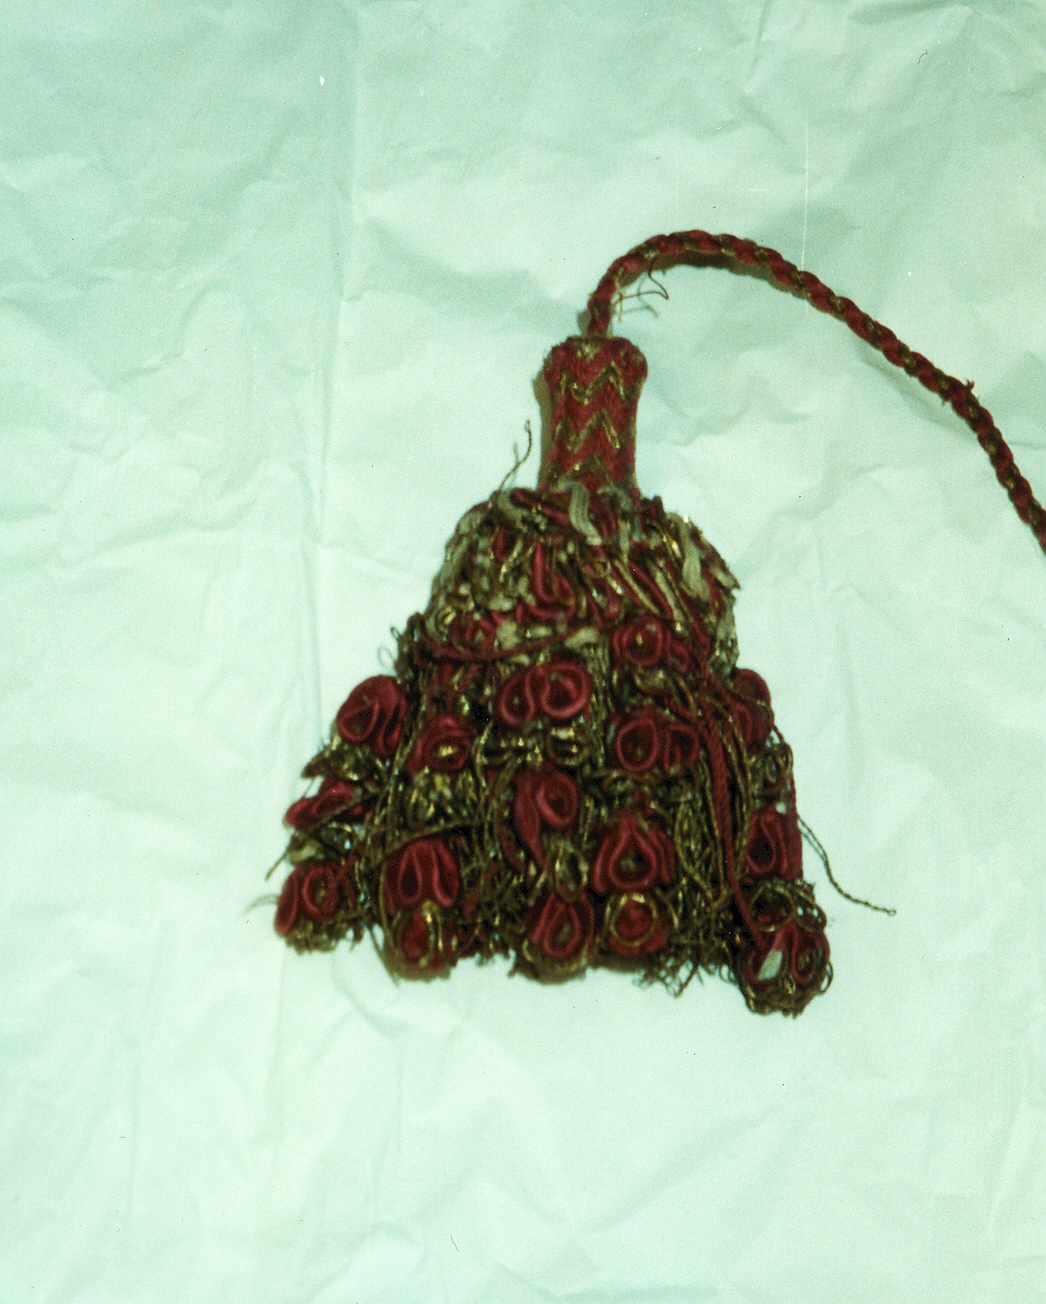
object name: tassel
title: Pair of tassels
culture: european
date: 1601-1900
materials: linen, metal, silk